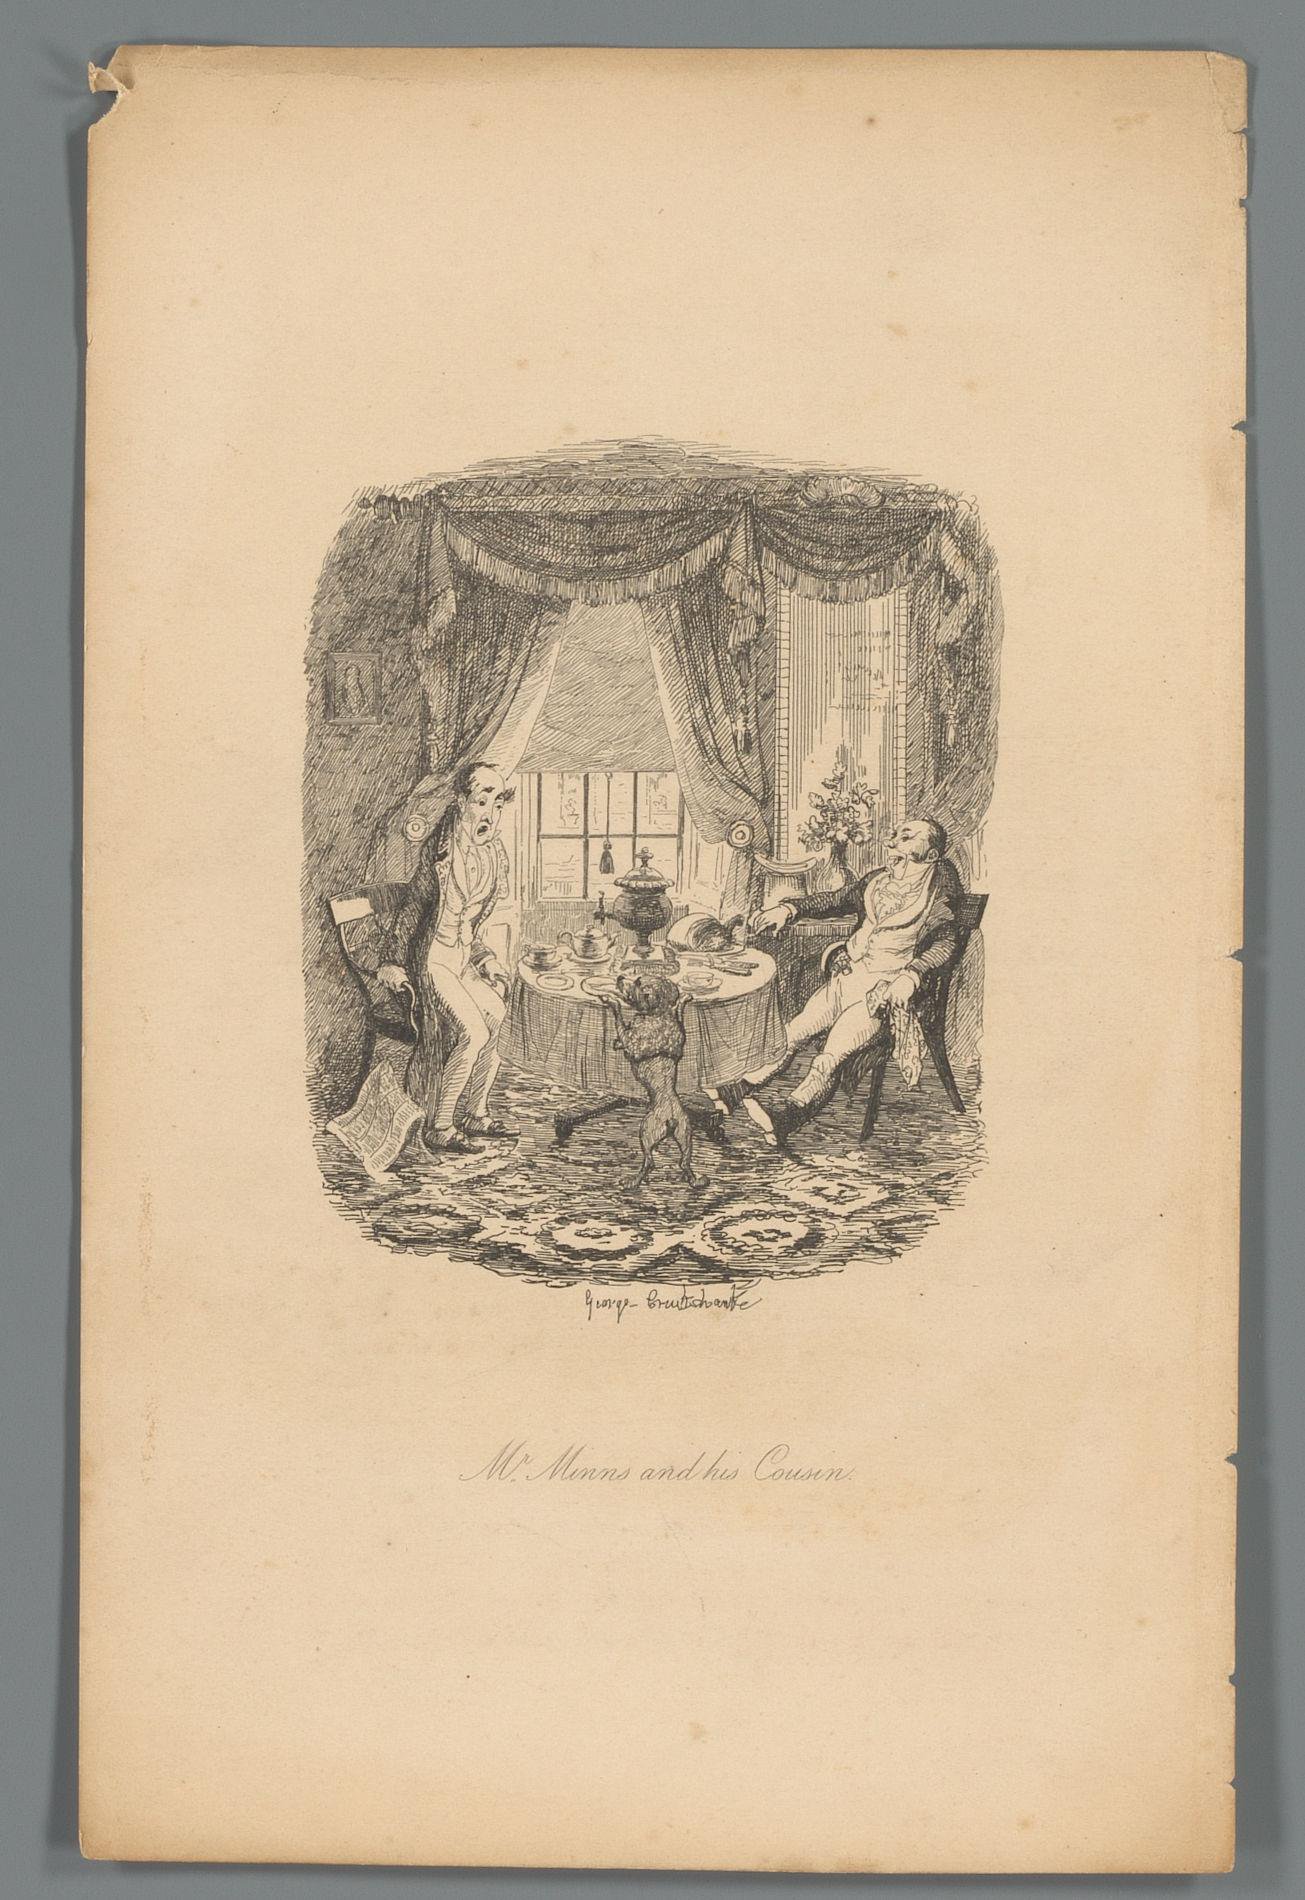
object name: cartoon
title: Mr. Minns and his Cousin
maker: george cruikshank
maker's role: painter, print maker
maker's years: 1792-1878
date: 1836-1839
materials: paper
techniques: etching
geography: england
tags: breakfast, political caricatures and satires, dog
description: Mr. Budding lacht als zijn hond eten van de ontbijttafel pakt, dit tot afschuw van Mr. Minns. Illustratie voor een uitgave van Sketches by 'Boz' van Charles Dickens, 1836-1839.